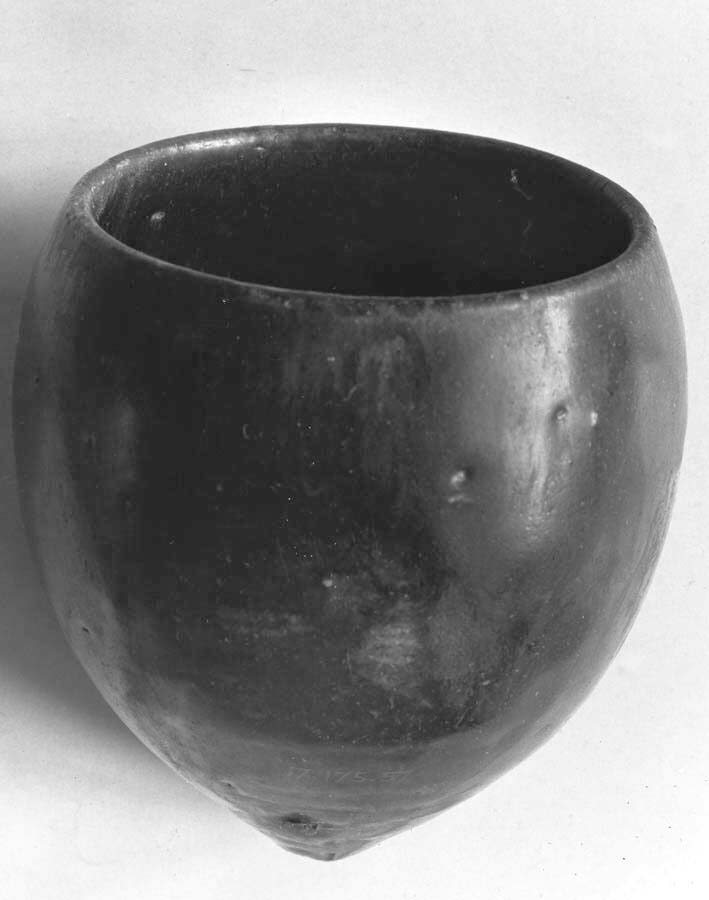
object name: cup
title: Conical cup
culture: korean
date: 1201-1300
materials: ceramic glaze, glaze, iron, stoneware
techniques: painting